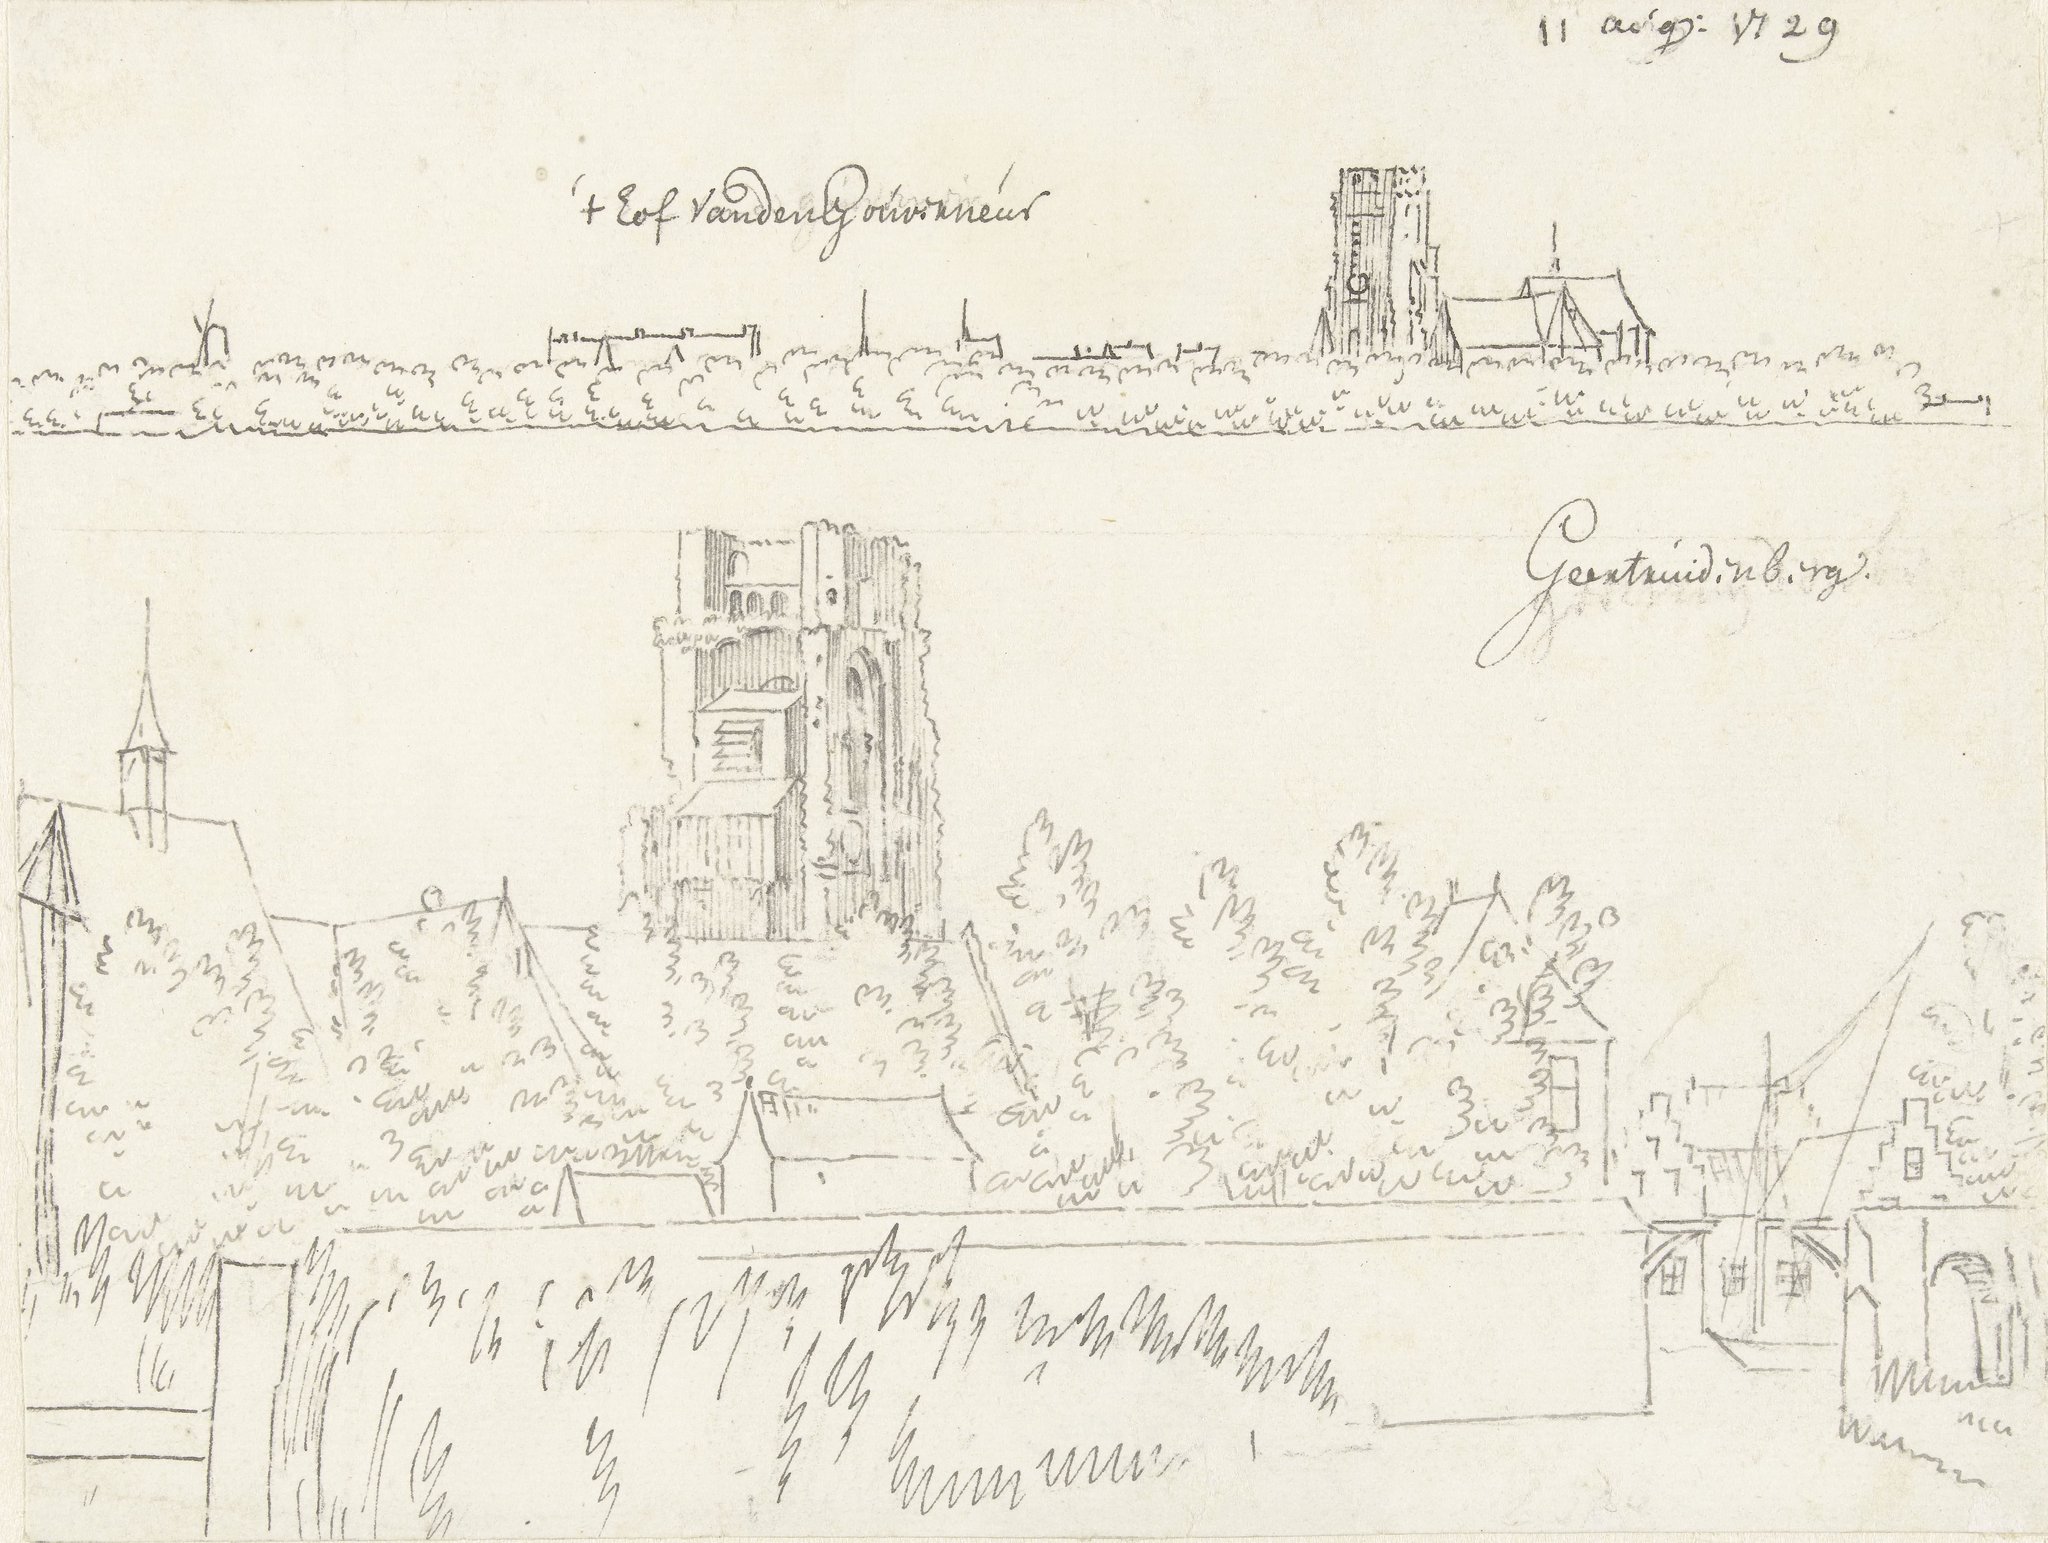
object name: drawing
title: Twee gezichten op Geertruidenberg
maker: cornelis pronk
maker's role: draughtsman, painter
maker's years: 1691-1759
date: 1729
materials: ink, paper, pencil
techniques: pen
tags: church (exterior), city-walls, prospect of city, town panorama, silhouette of city, geertruidenberg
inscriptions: inscription: ‘11 aug 1729 / 't hof vanden Gouverneur / Geertruidenberg’